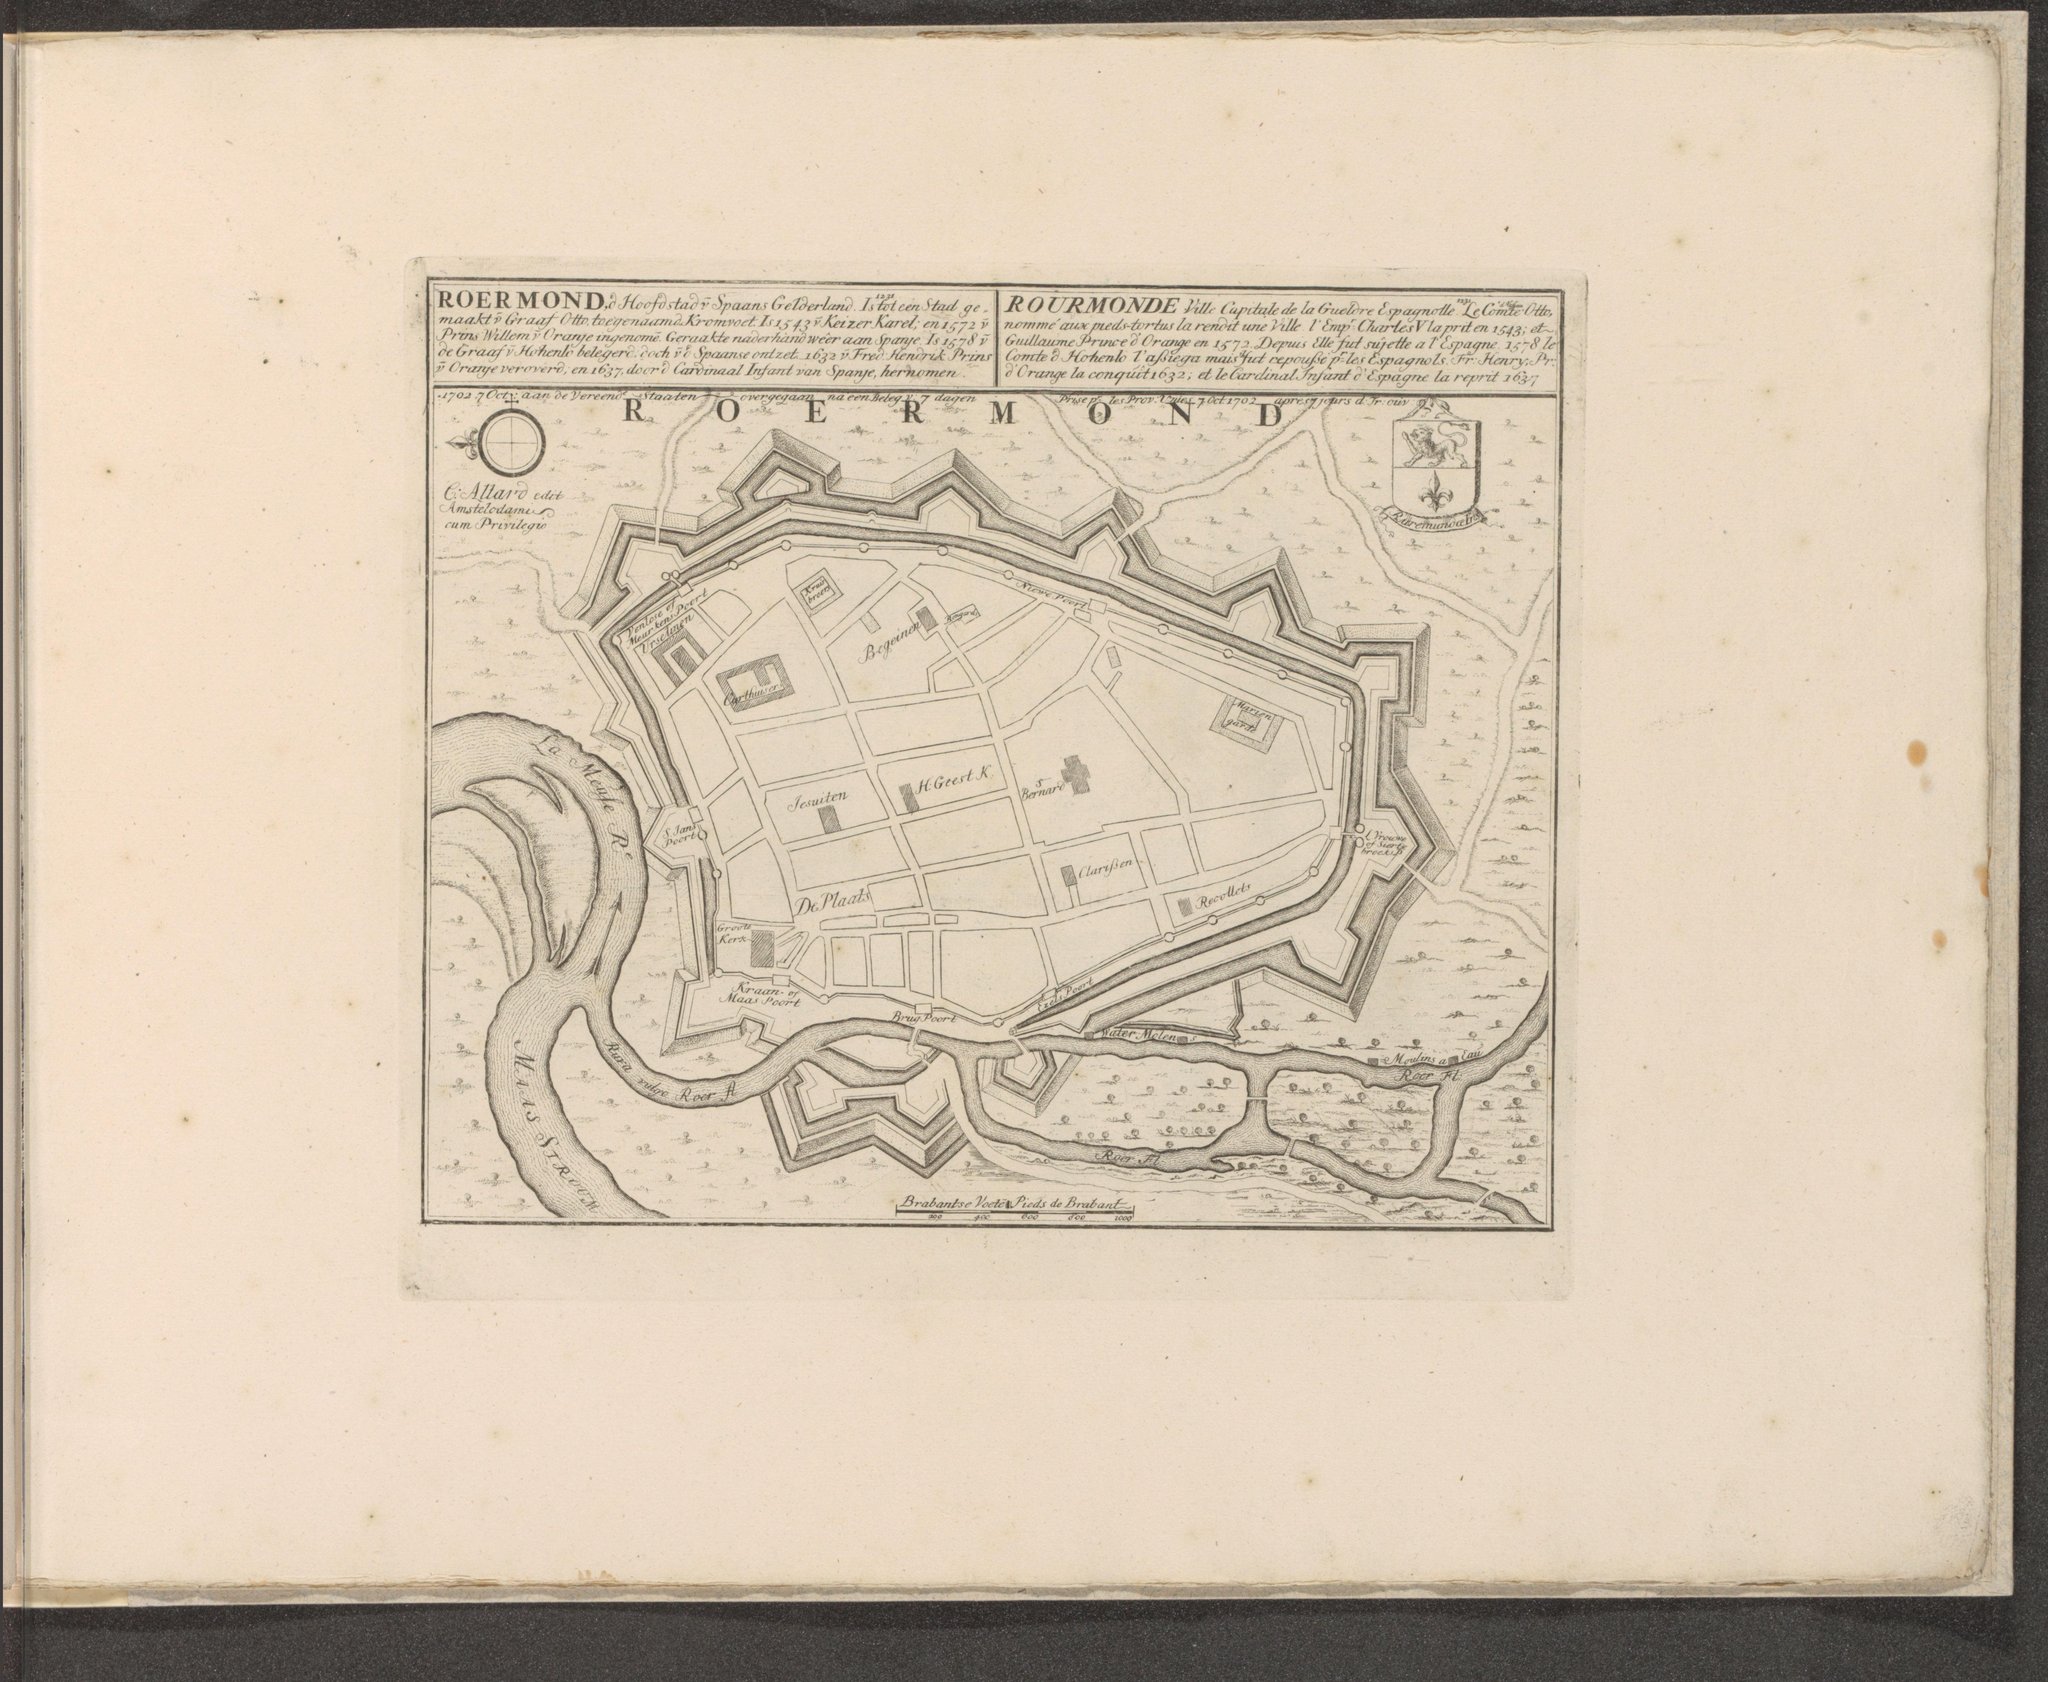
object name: album leaf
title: Roermond, d Hoofdstad v[an] Spaans Gelderland (...) 1702 7 Oct: aan de Vereende Staaten overgegaan na een beleg v[an] 7 dagen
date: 1702-1733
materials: paper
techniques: etching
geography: leiden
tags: fortifications, military engineering, maps of cities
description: Plattegrond van de stad Roermond. Na beleg overgegaan naar de Verenigde Nederlanden, 7 oktober 1702. Met teksten in het Nederlands en Frans. De prent maakt deel uit van een album.